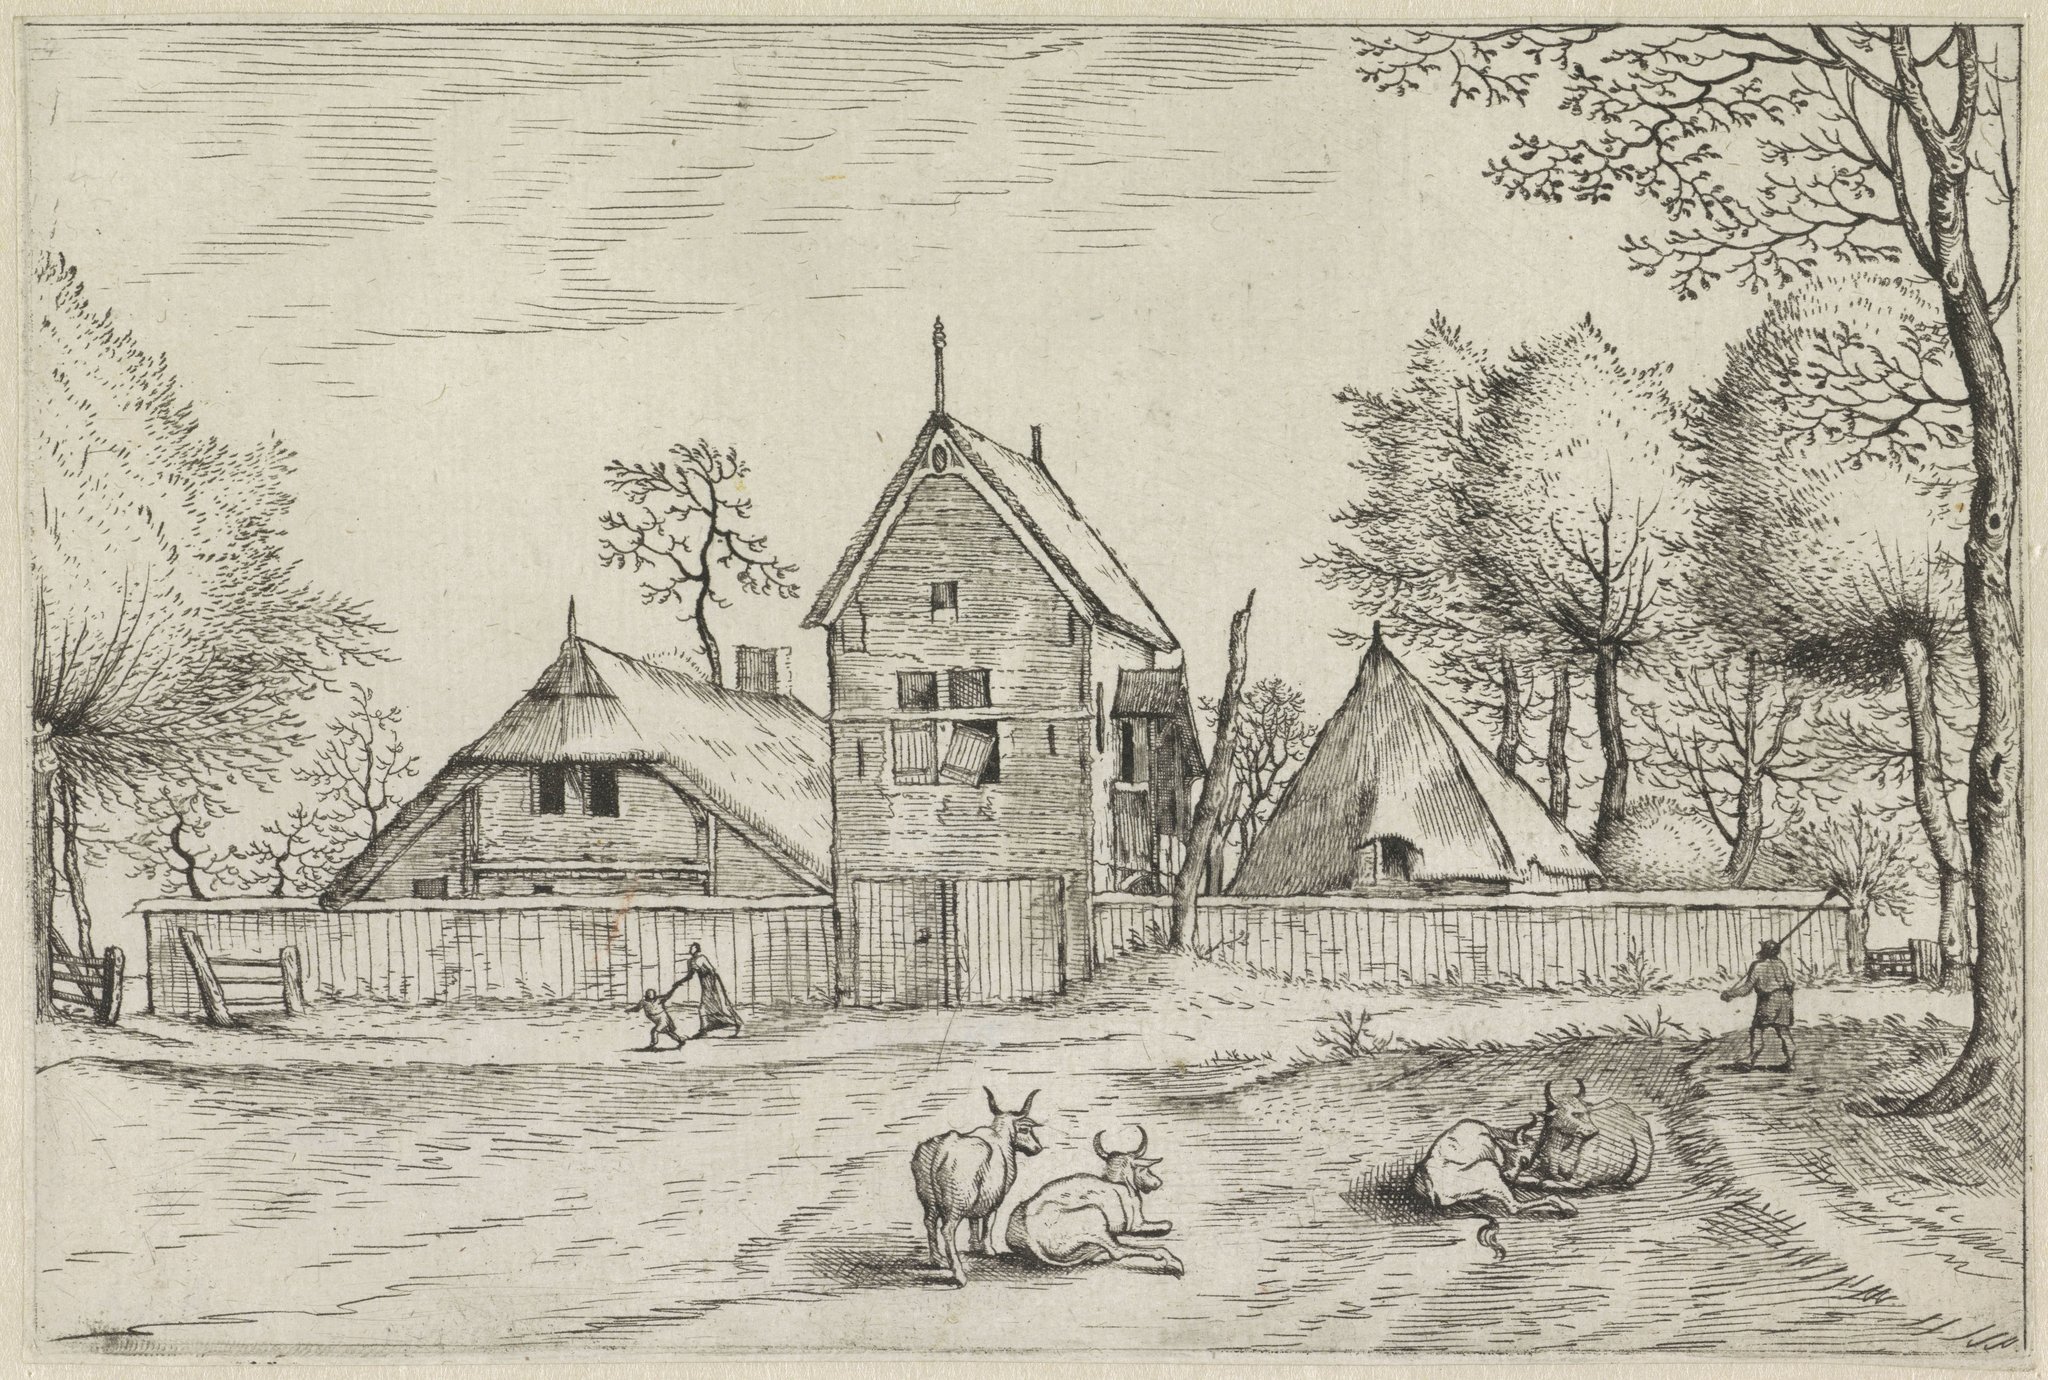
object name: print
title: Kleine landschappen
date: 1559-1561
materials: paper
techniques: etching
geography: antwerp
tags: cow, farm (building)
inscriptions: collector's mark: Lugt 2228, collector's mark: Lugt 2760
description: Een ommuurde boerenhofstede. Op de voorgrond een moeder met kind, koeien en een veehoeder.